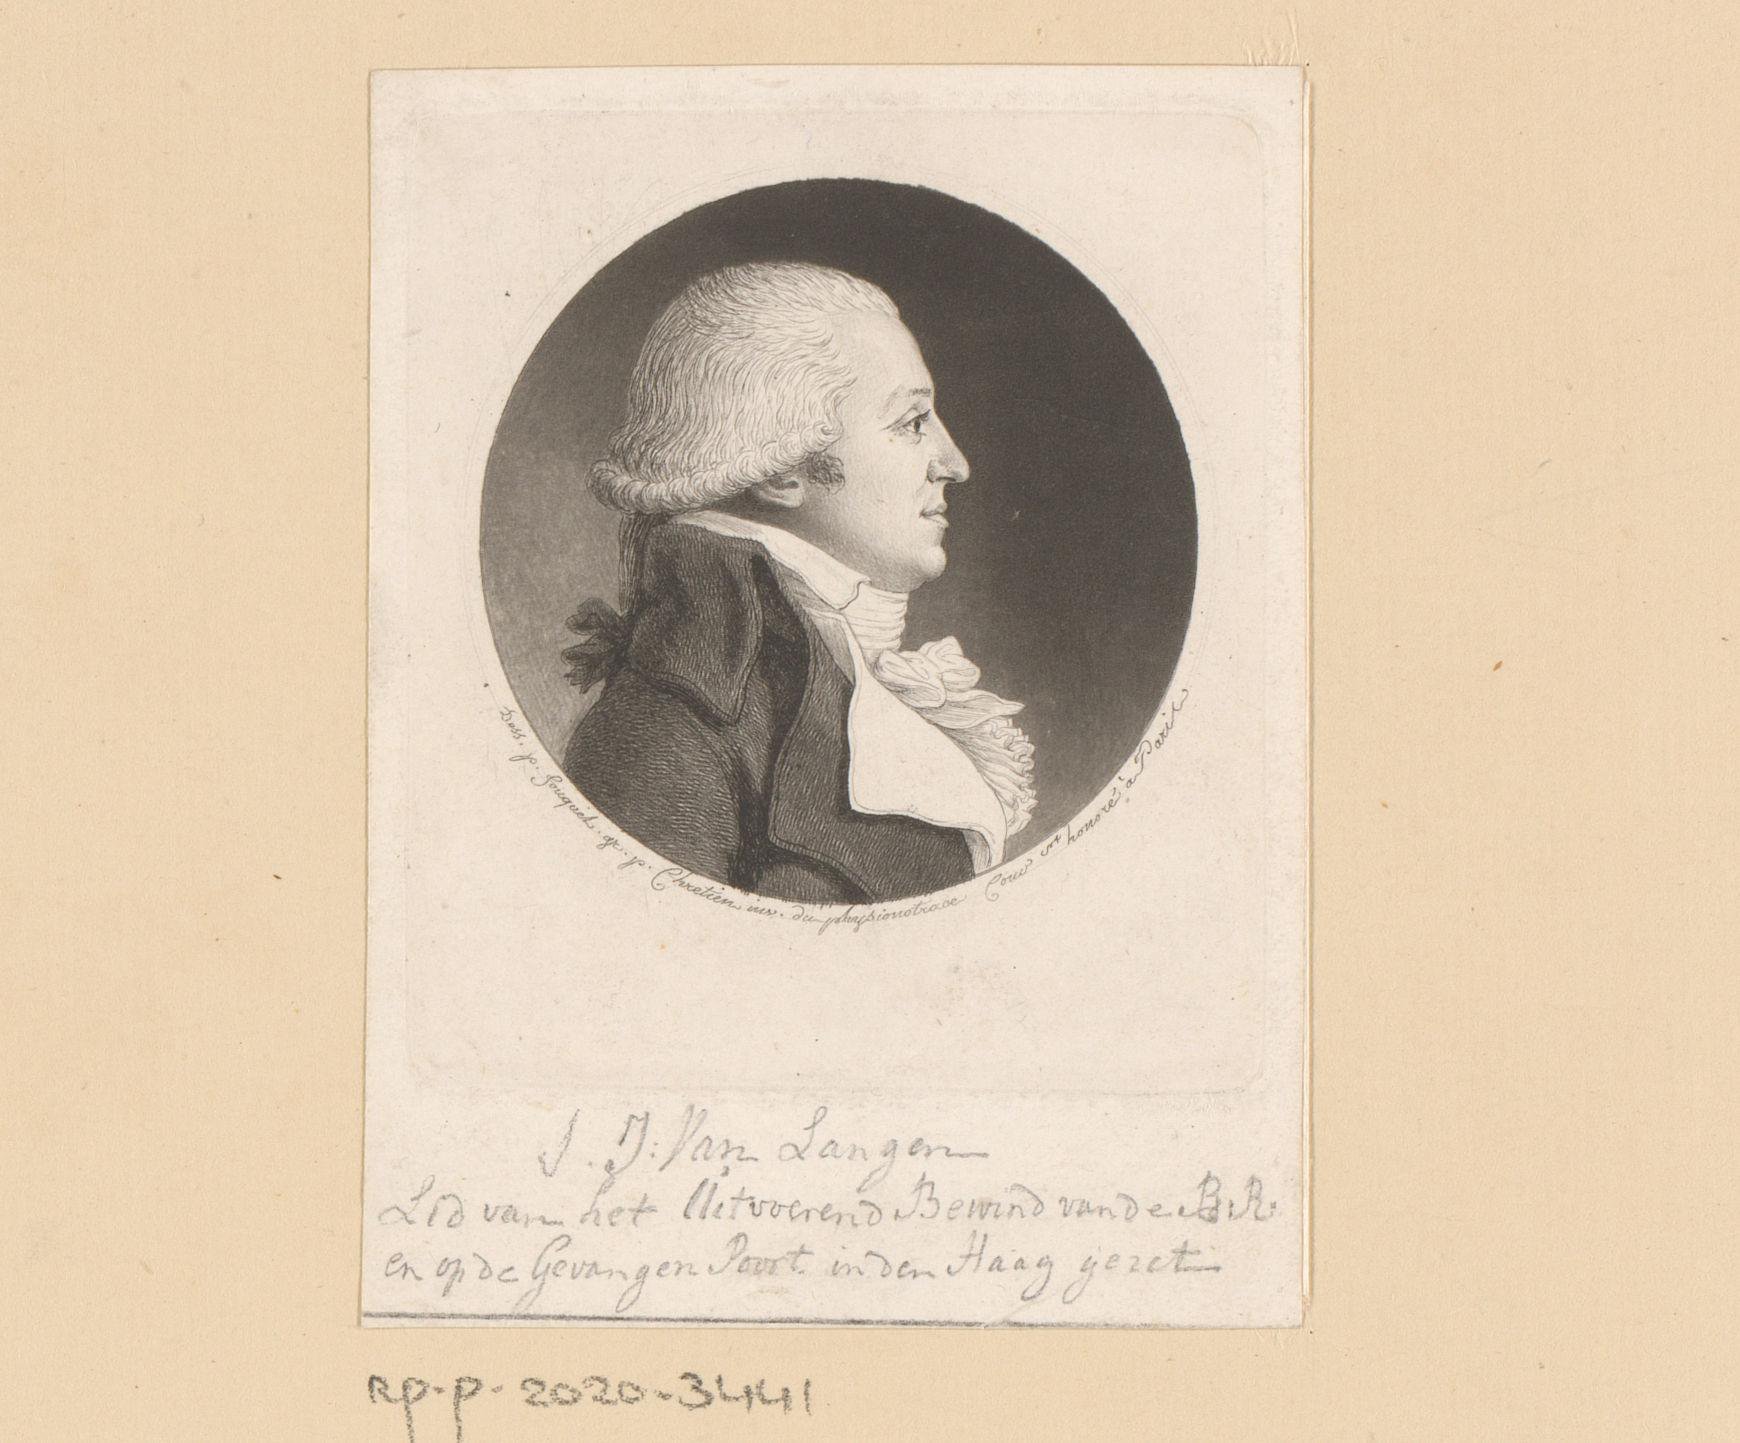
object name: physionotrace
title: Portret van Stefanus Jacobus van Langen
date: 1785-1811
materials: paper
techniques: aquatint, etching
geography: paris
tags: silhouette-apparatus, 'physionotrace', historical persons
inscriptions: collector's mark: Lugt 2166